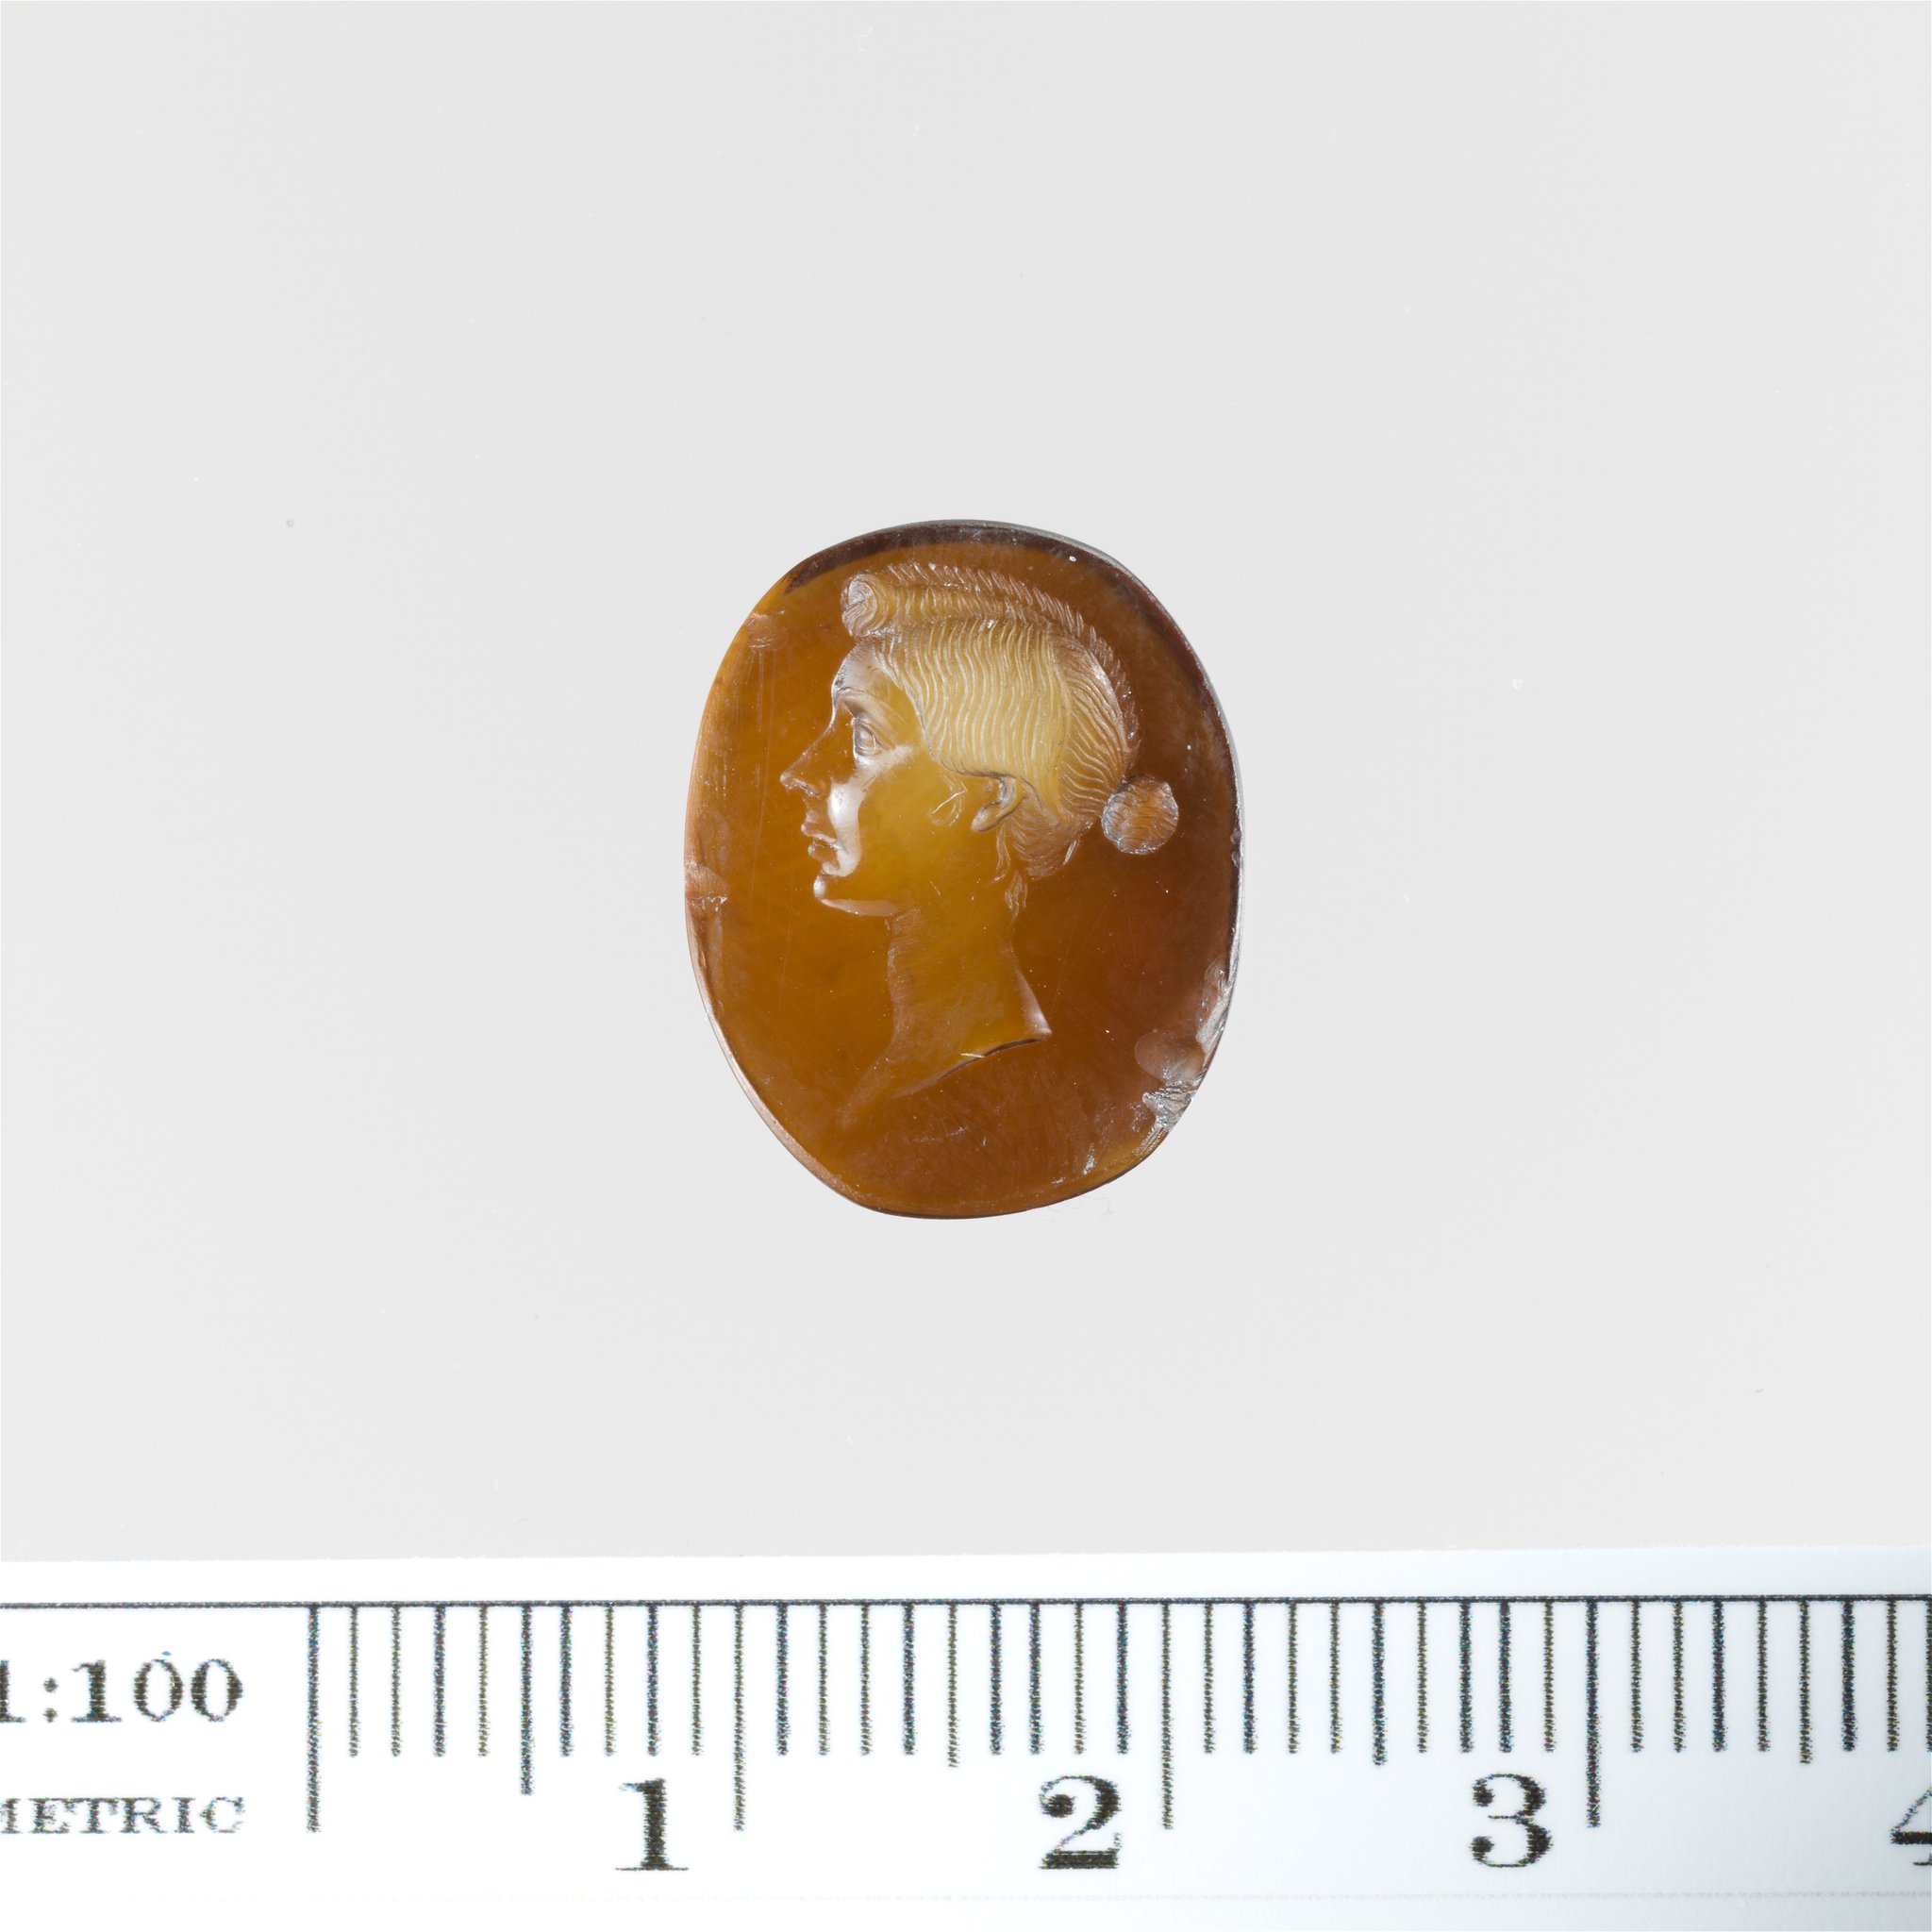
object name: ring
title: Sard ring stone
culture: roman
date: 1-100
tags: women